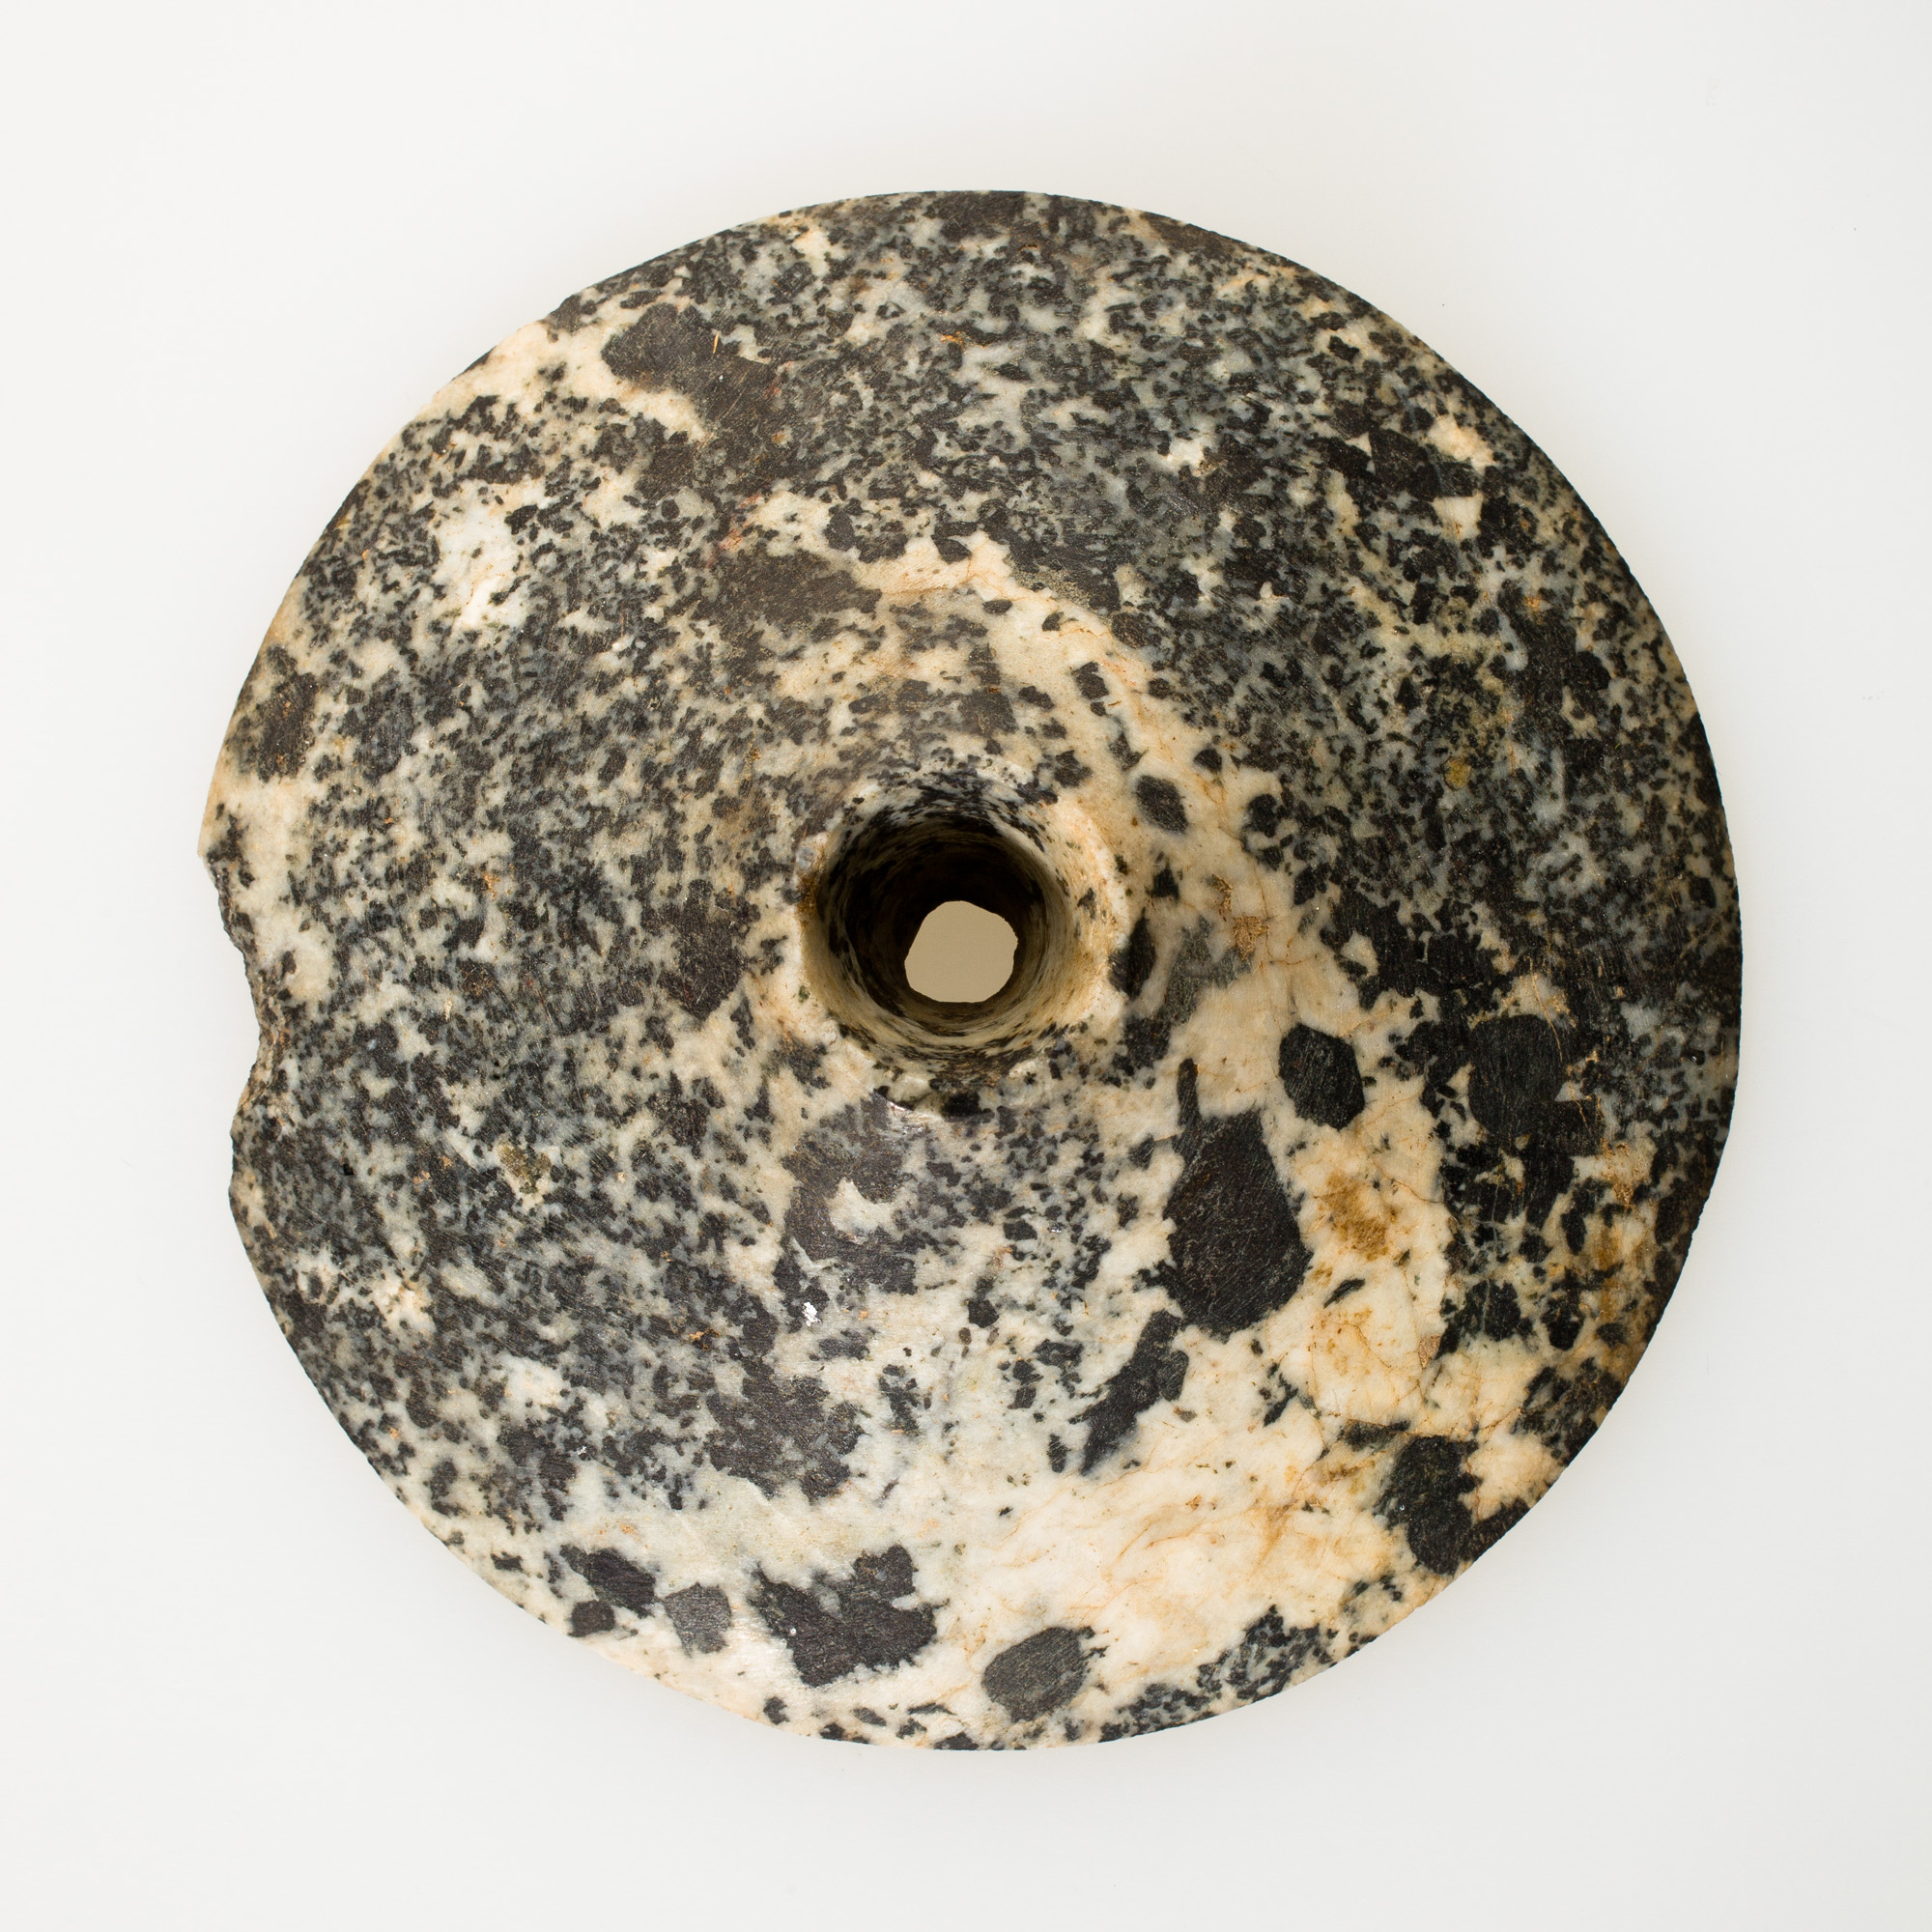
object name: mace head, disc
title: Disc-shaped mace head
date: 4500-4000 BCE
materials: stone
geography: egypt